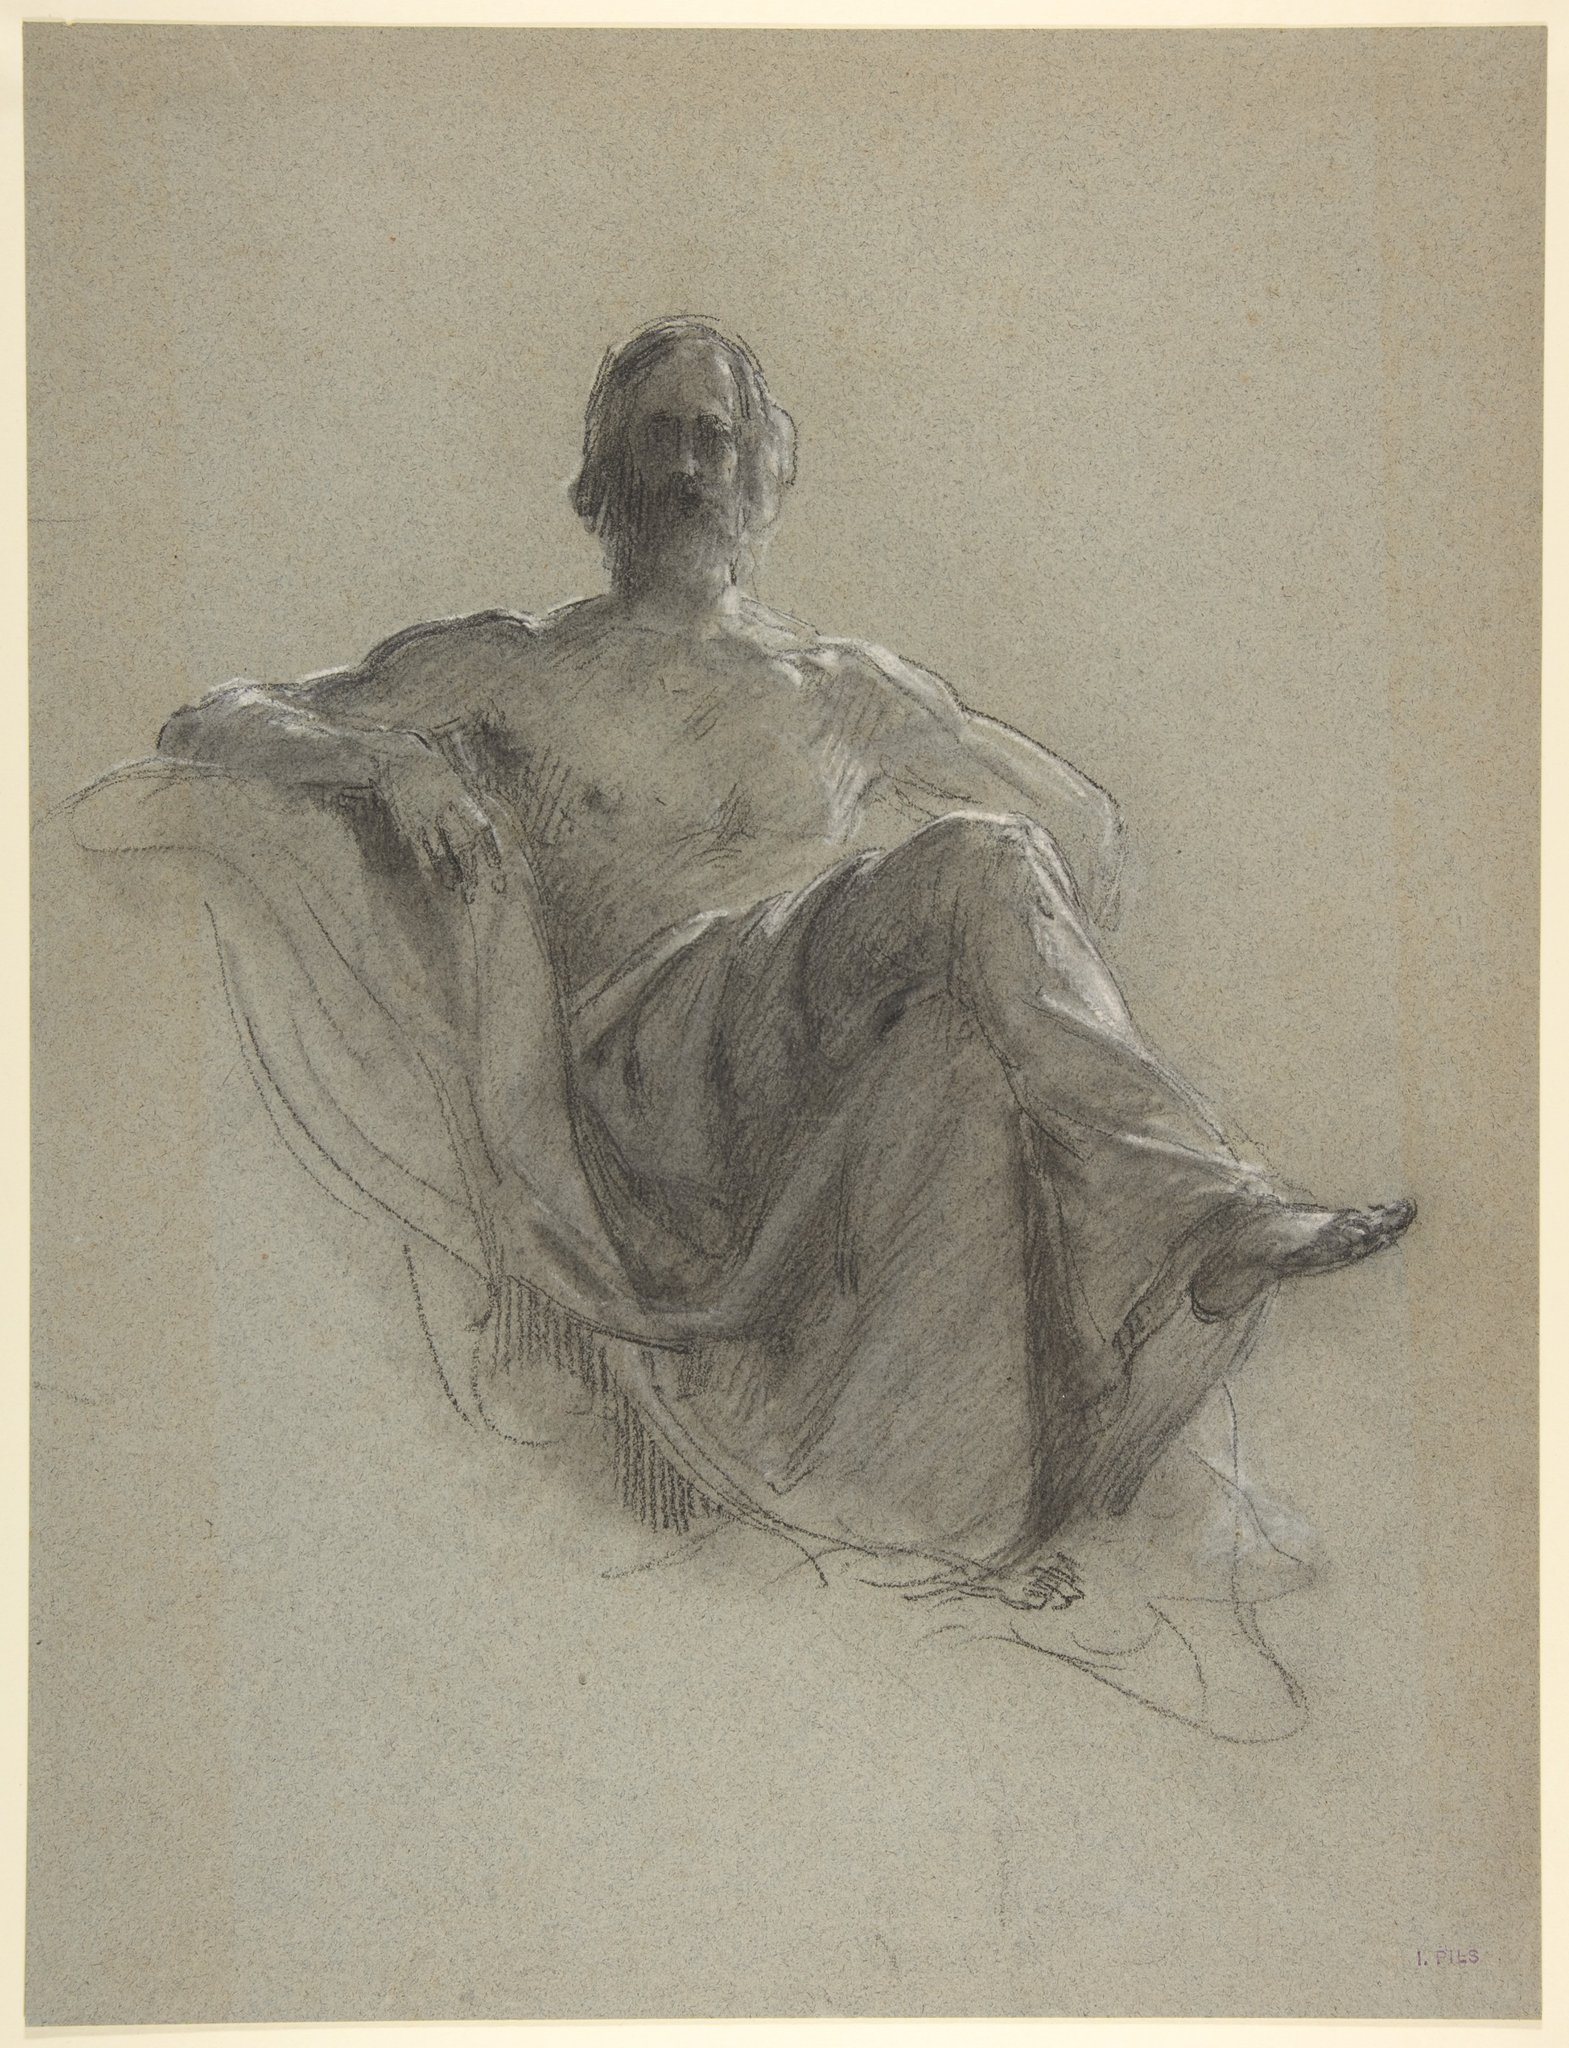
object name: drawing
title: Seated Bearded Man, Nude to the Waist (Jupiter Seated)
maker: isidore pils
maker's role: artist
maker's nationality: french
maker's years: 1813-1875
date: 1801-1900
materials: chalk, paper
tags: men,jupiter